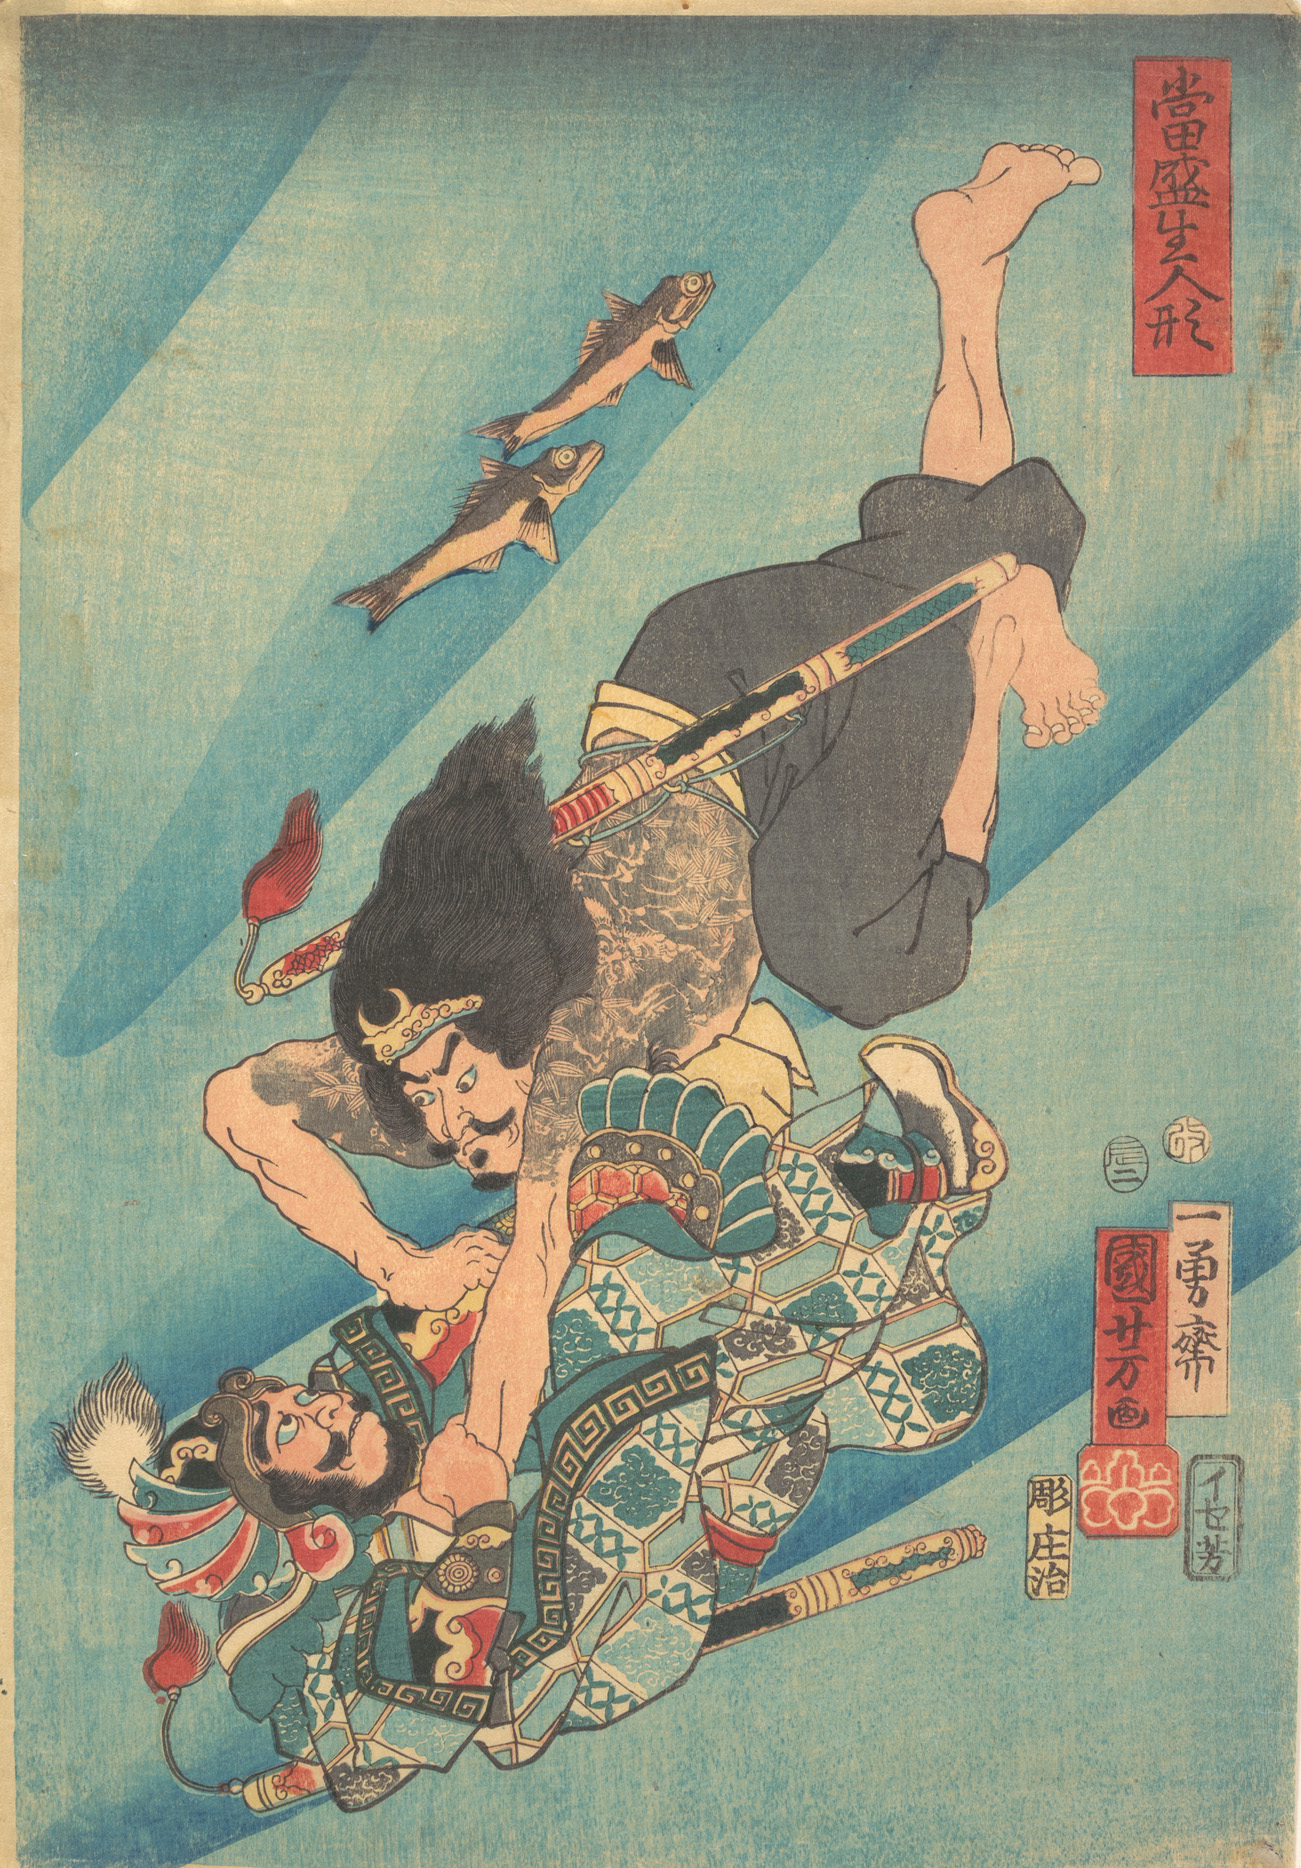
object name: print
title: Tanmeijirō Genshōgo Fighting Under Water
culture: japanese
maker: utagawa kuniyoshi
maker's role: artist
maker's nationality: japanese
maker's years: 1797-1861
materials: ink, paper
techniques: woodblock print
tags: swords,men